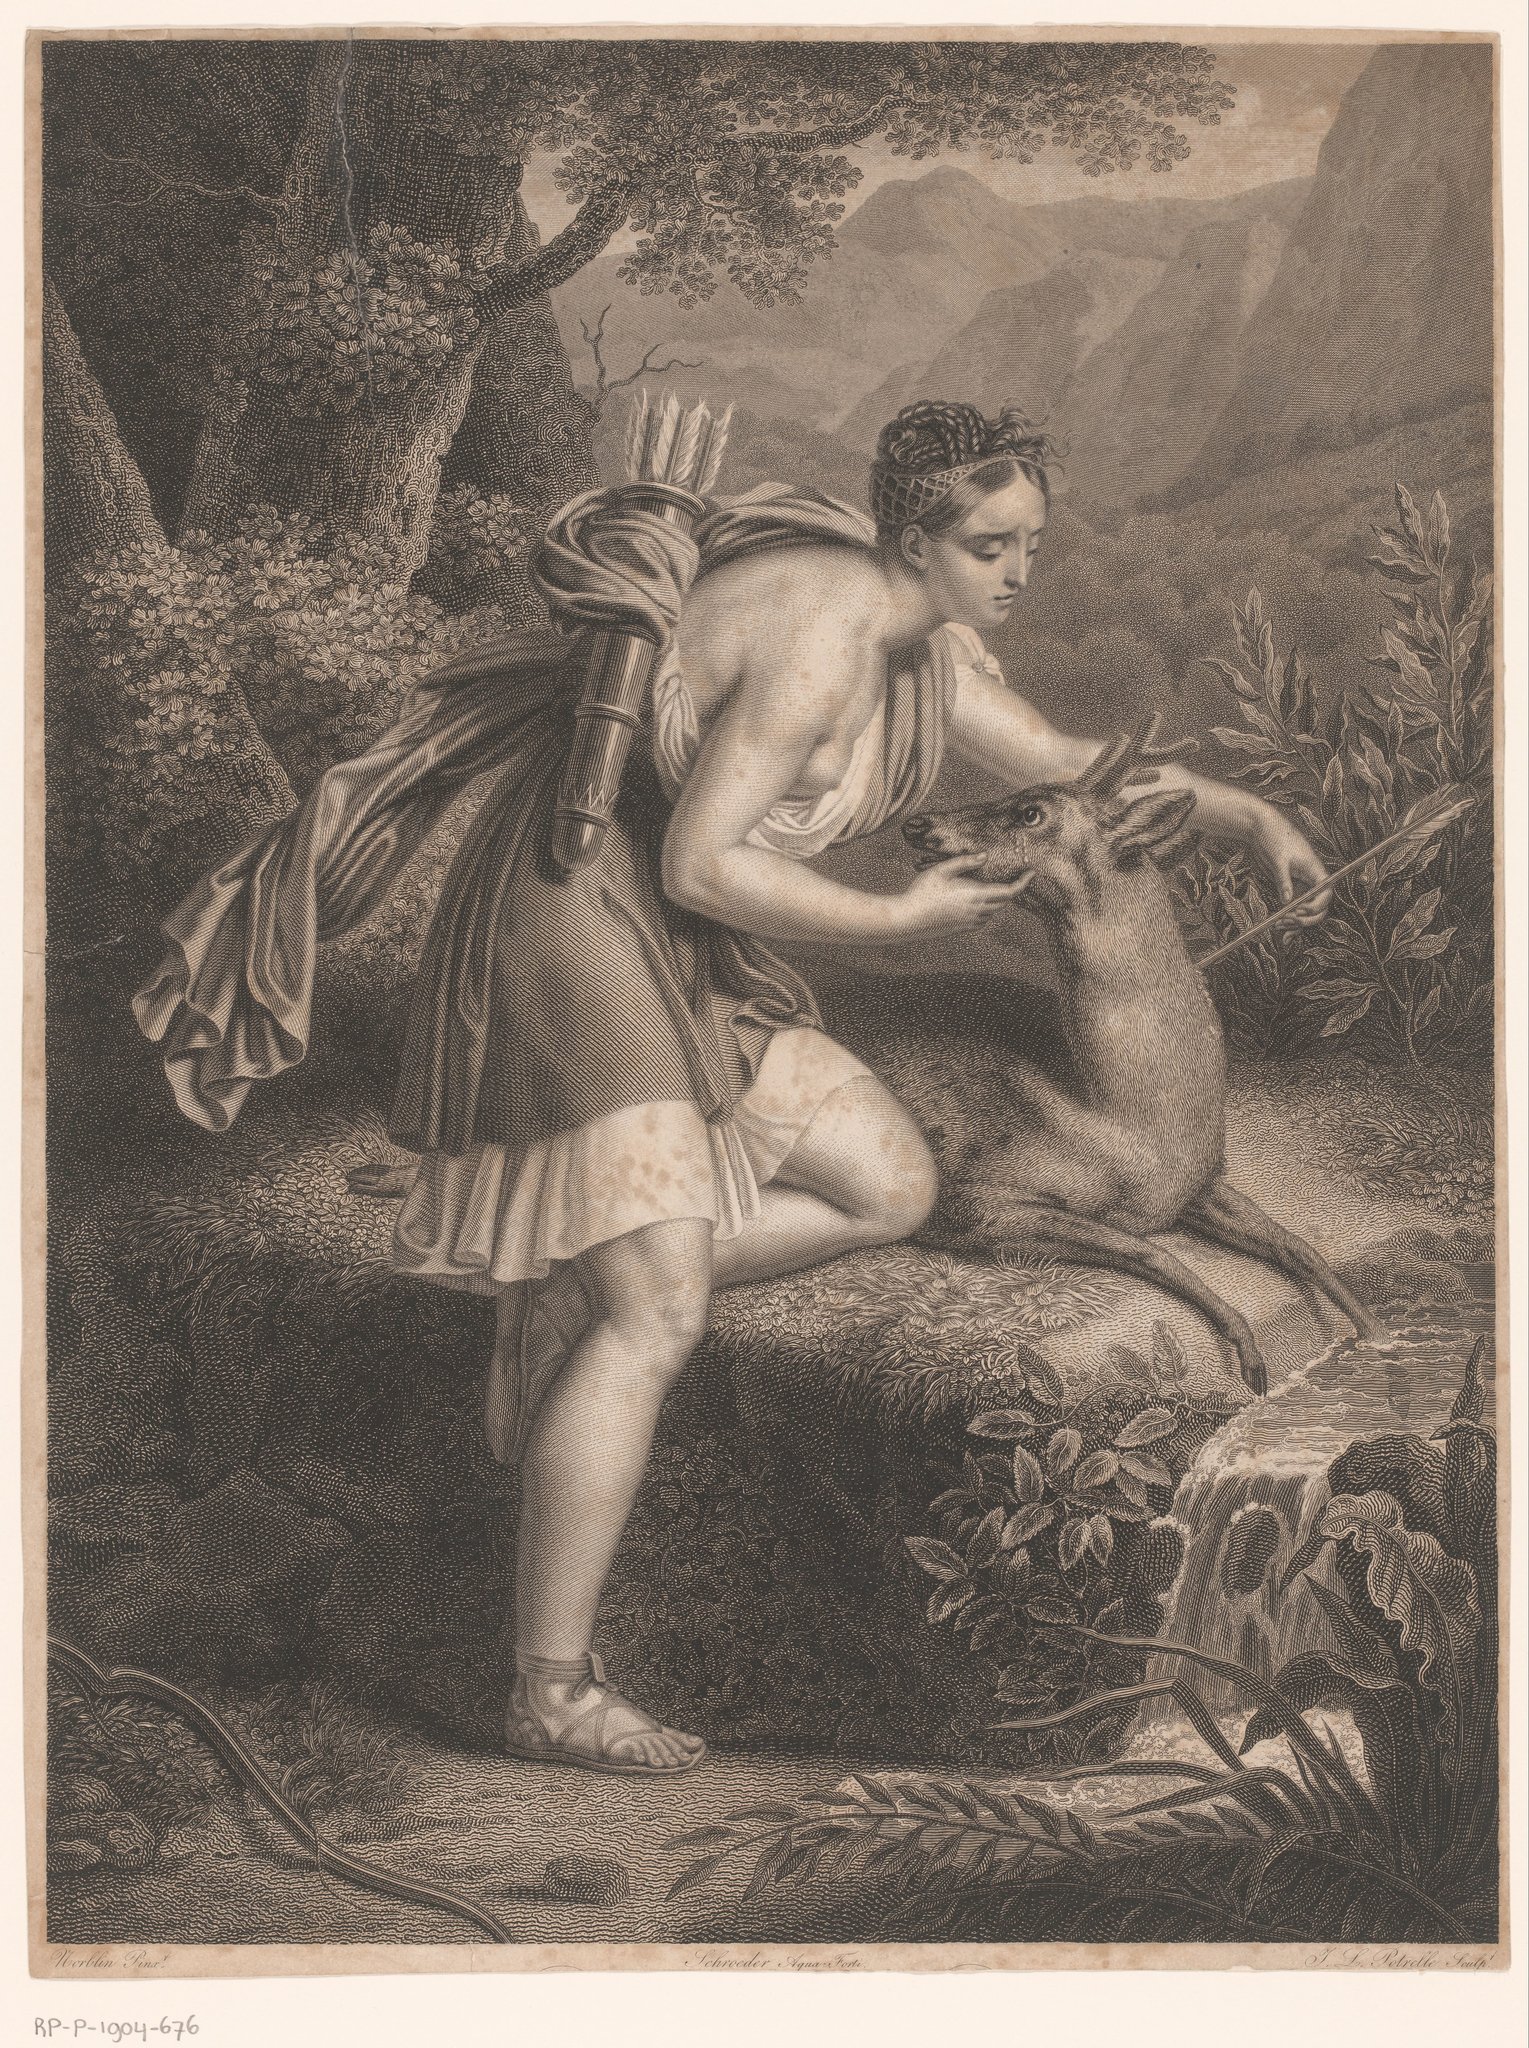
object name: print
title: Nimf van Diana haalt een pijl uit de hals van een hert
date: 1798-1824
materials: paper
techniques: engraving, etching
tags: companions, nymphs of diana; 'ninfe di diana' (ripa), hoofed animals: deer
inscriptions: collector's mark: Lugt 2228